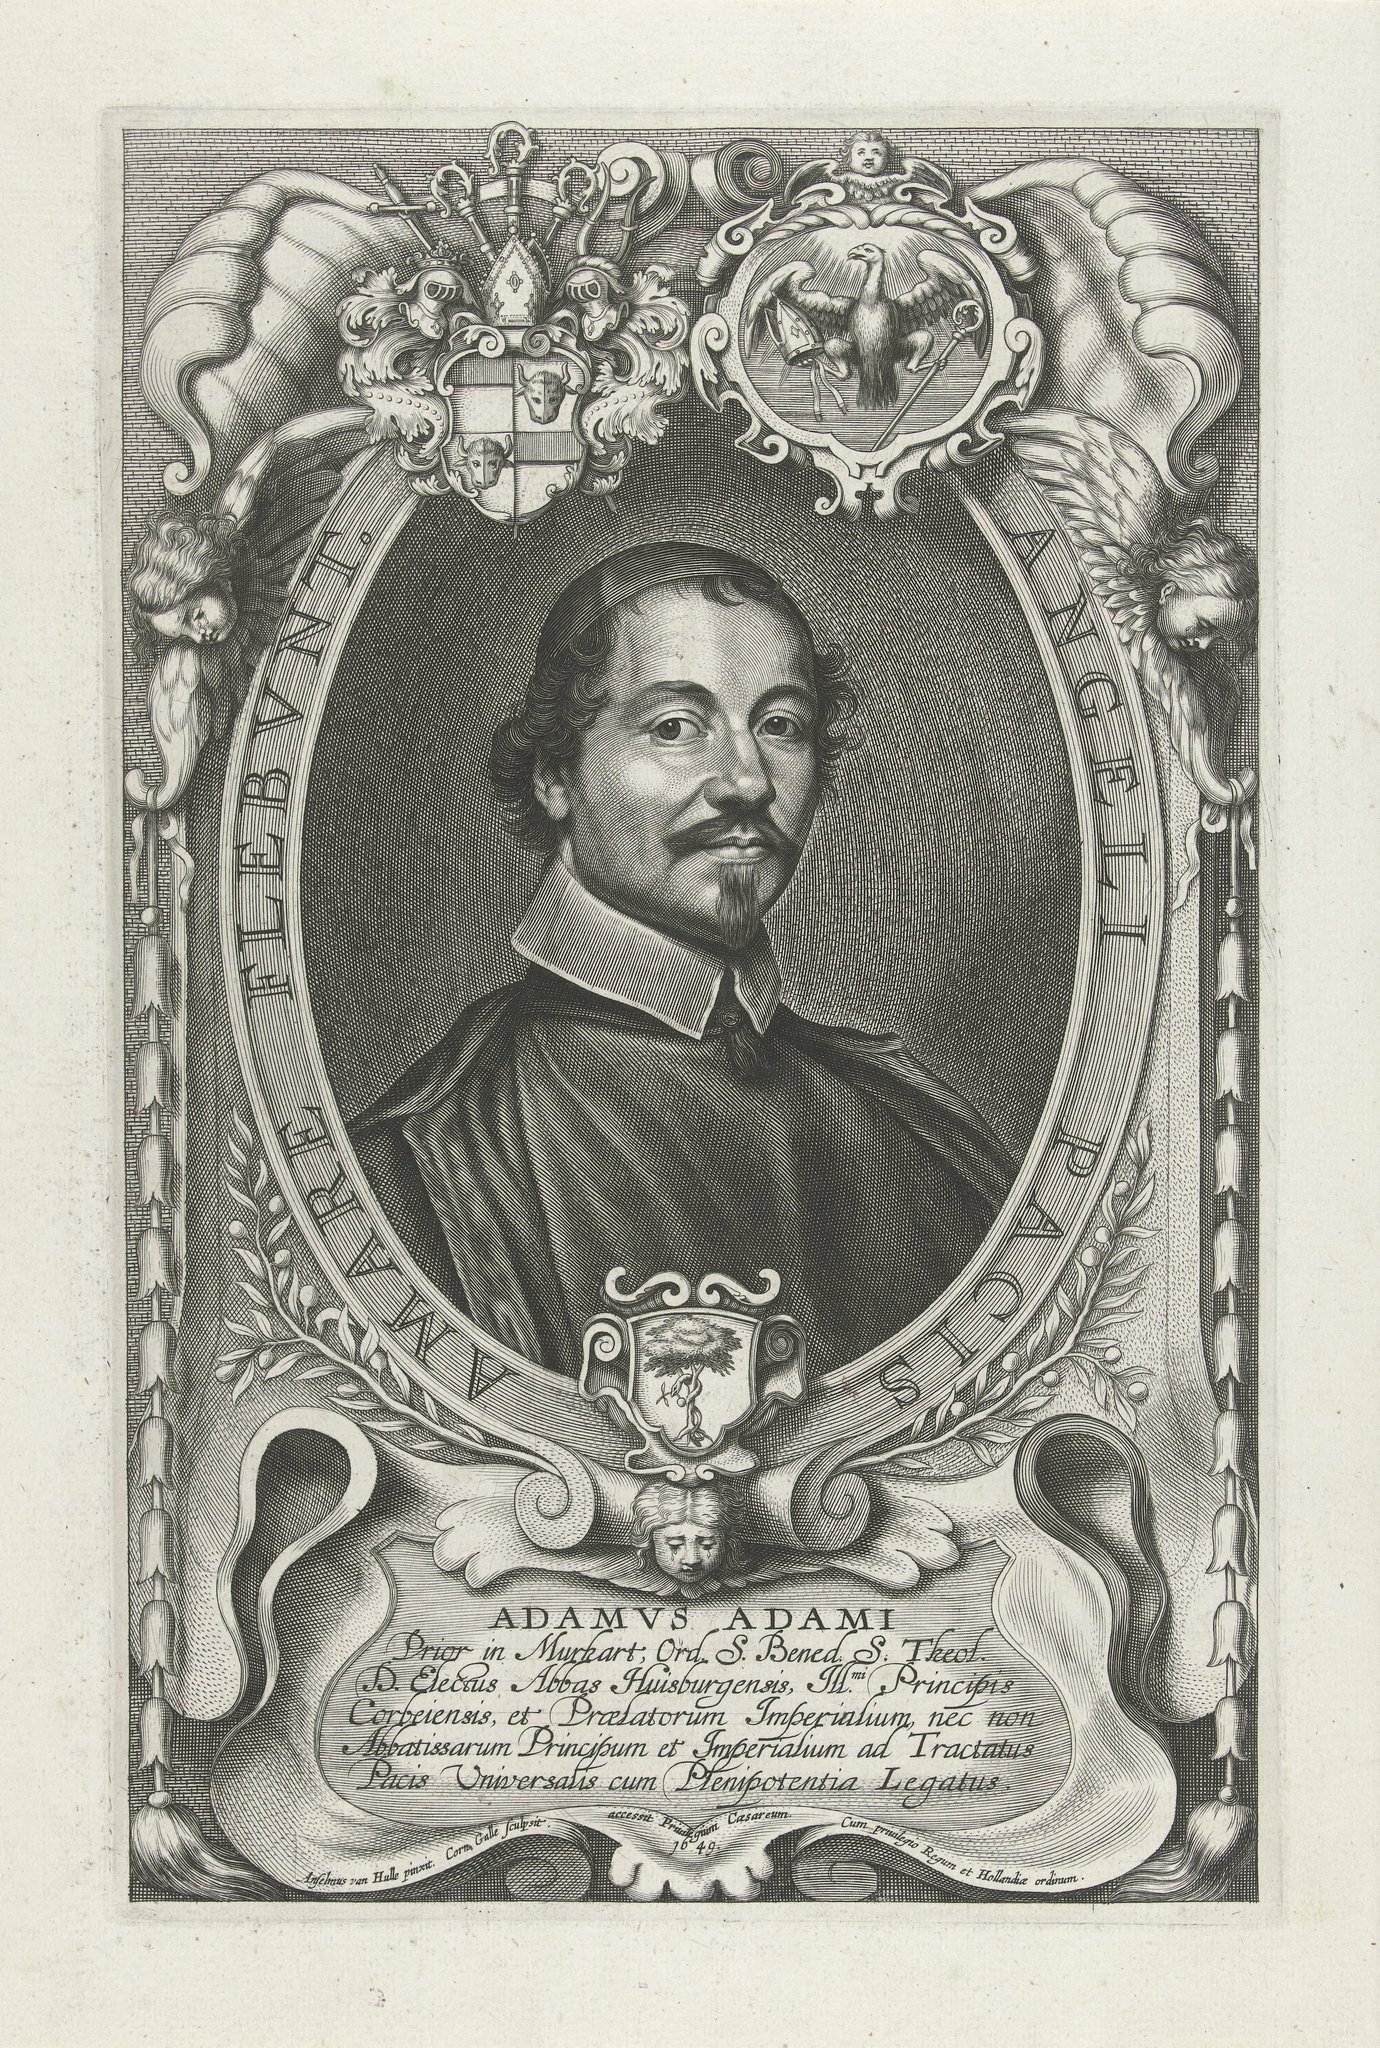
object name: print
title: Portret van Adam Adami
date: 1649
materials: paper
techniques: engraving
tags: hildesheim, bisschop, abt, afgezant, prior, adam adami, vrede van münster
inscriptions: collector's mark: Lugt 2228, inscription: ‘offi [...] temporis abbate corbeijensis’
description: Portret van Adam Adami, afgevaardigde bij de onderhandelingen rond de Vrede van Münster, in ovaal met sierlijst. In de lijst zijn drie wapens verwerkt.